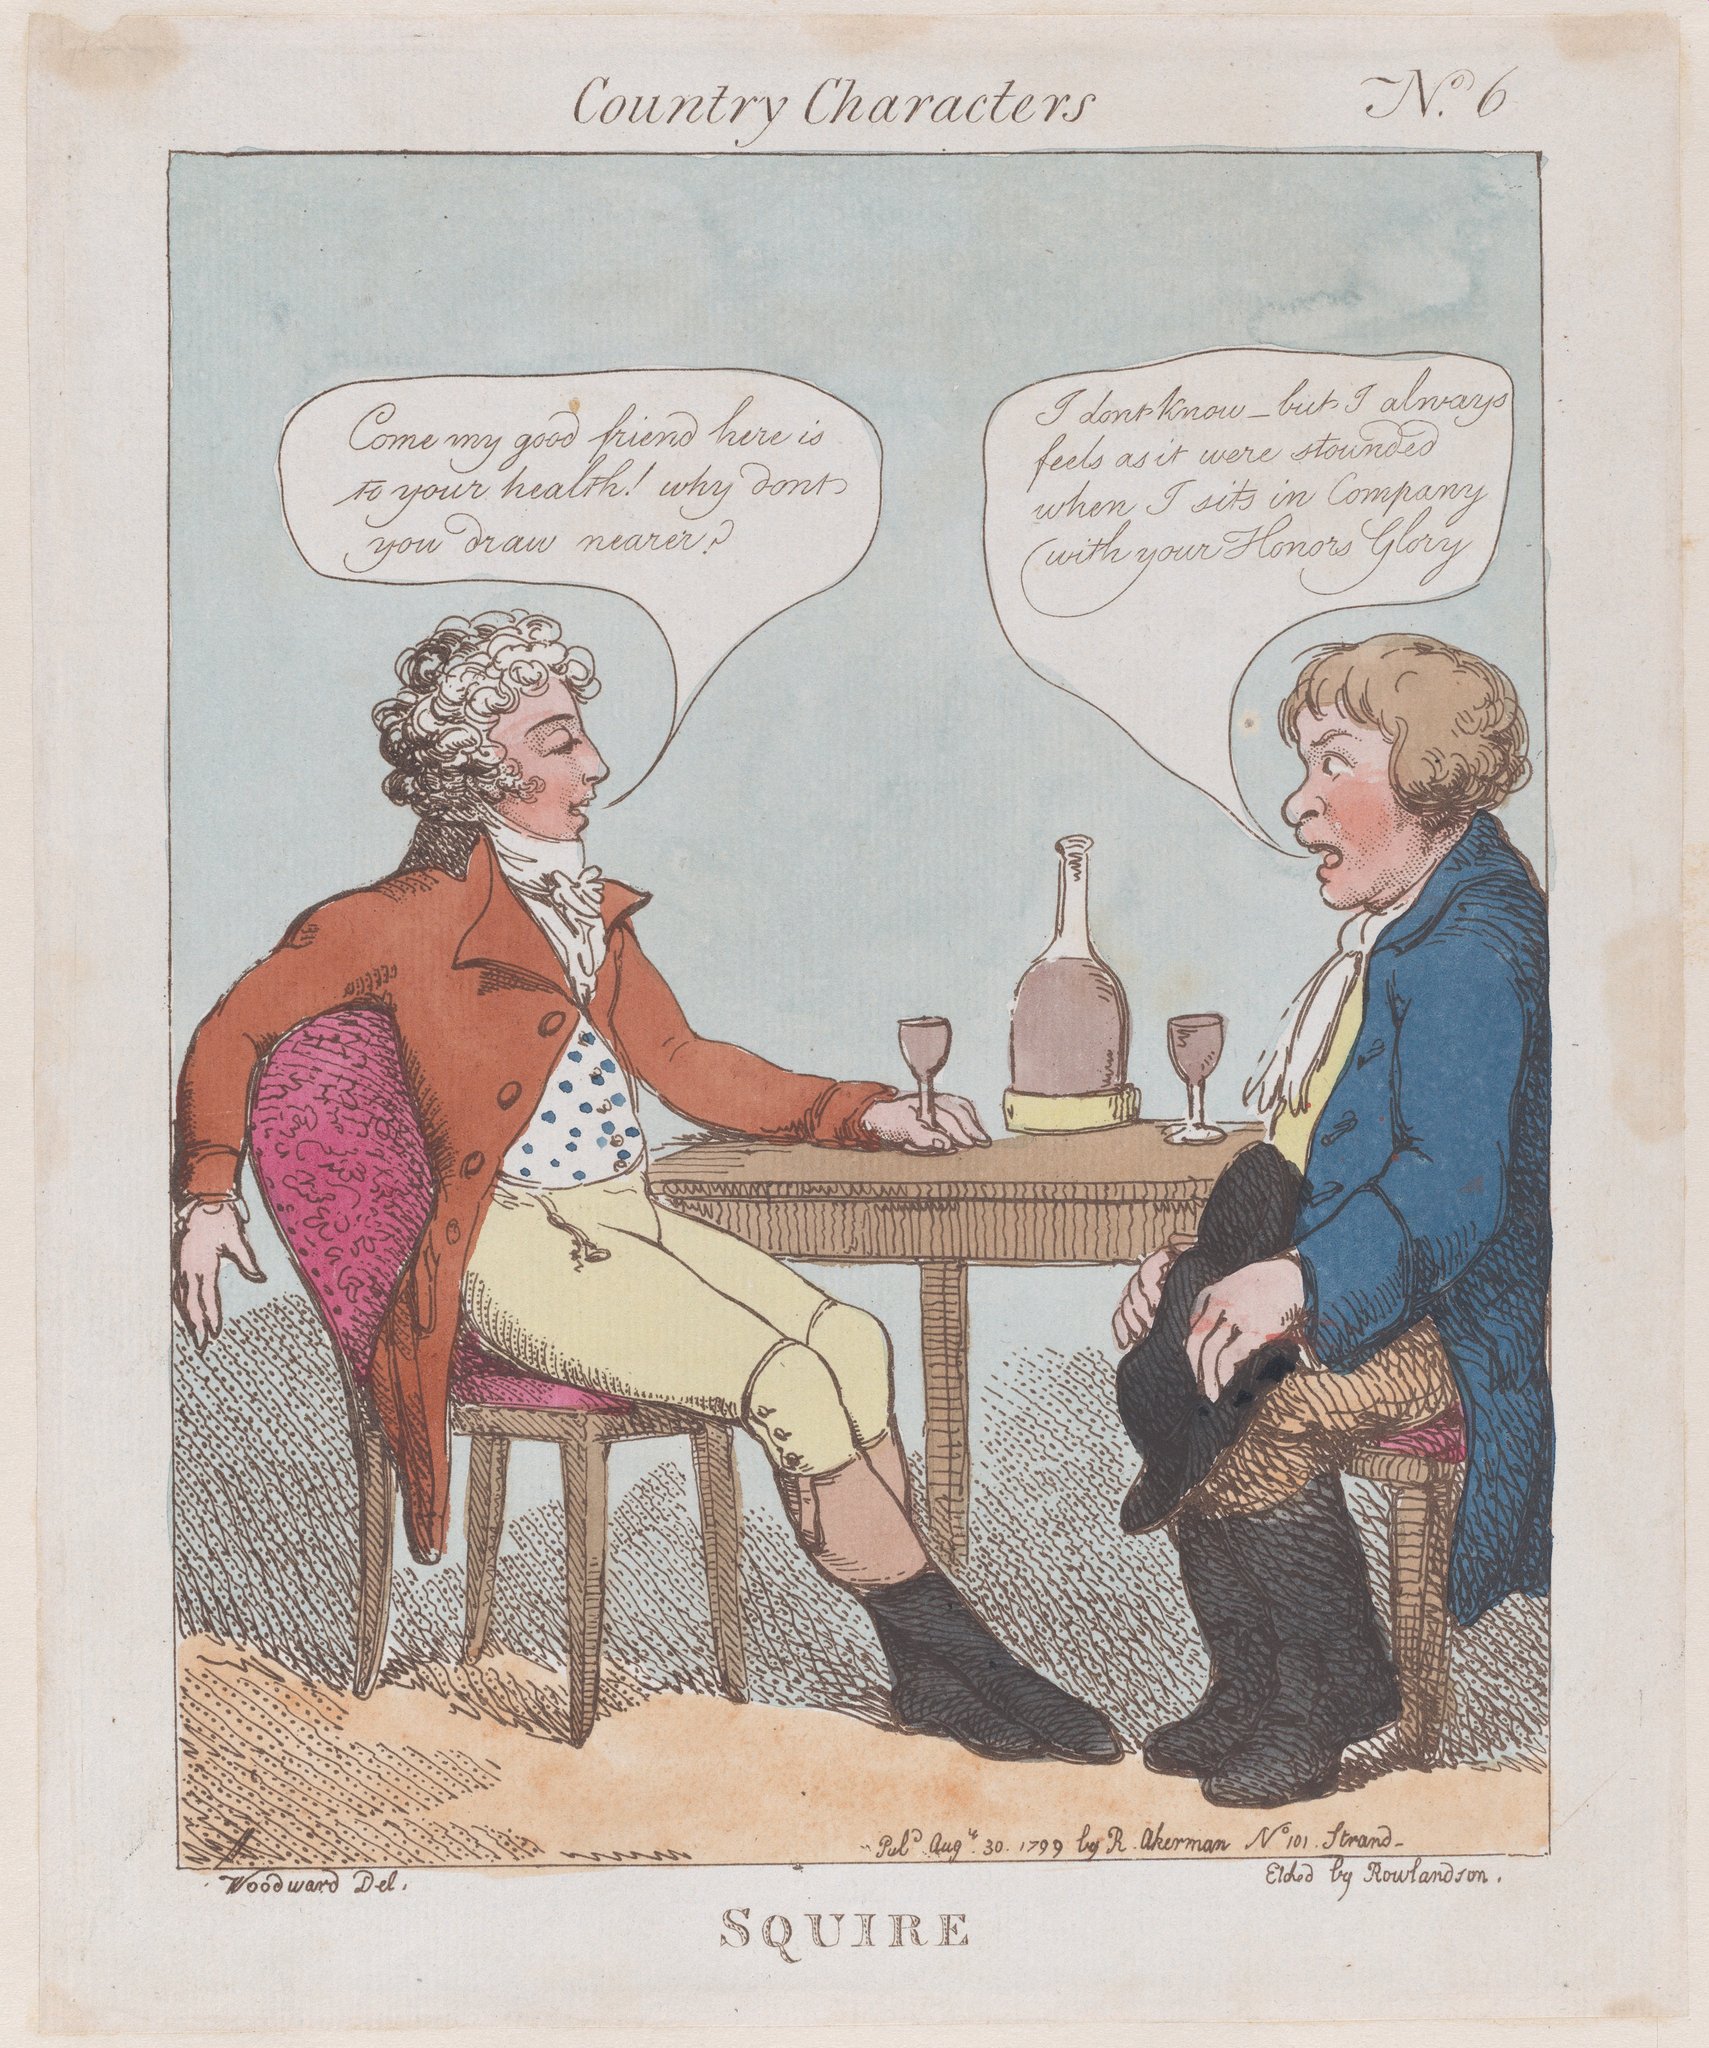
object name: print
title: Squire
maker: thomas rowlandson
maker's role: artist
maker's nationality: british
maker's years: 1757-1827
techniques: etching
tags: satire,men